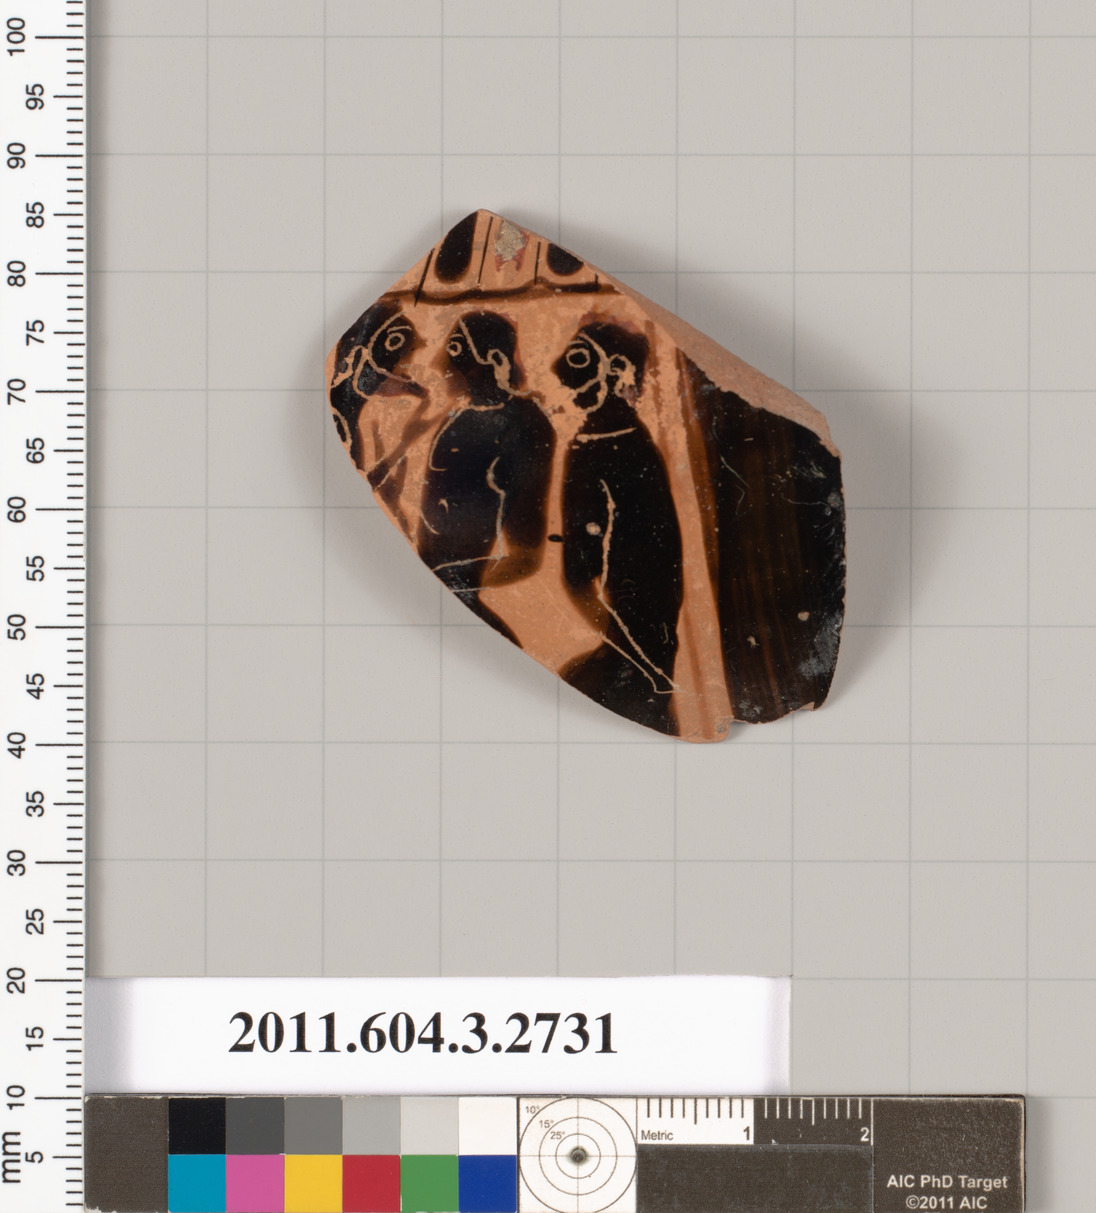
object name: oinochoe fragment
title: Terracotta fragment of a trefoil oinochoe (jug)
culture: greek, attic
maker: burgon group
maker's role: artist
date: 575-551 BCE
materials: terracotta